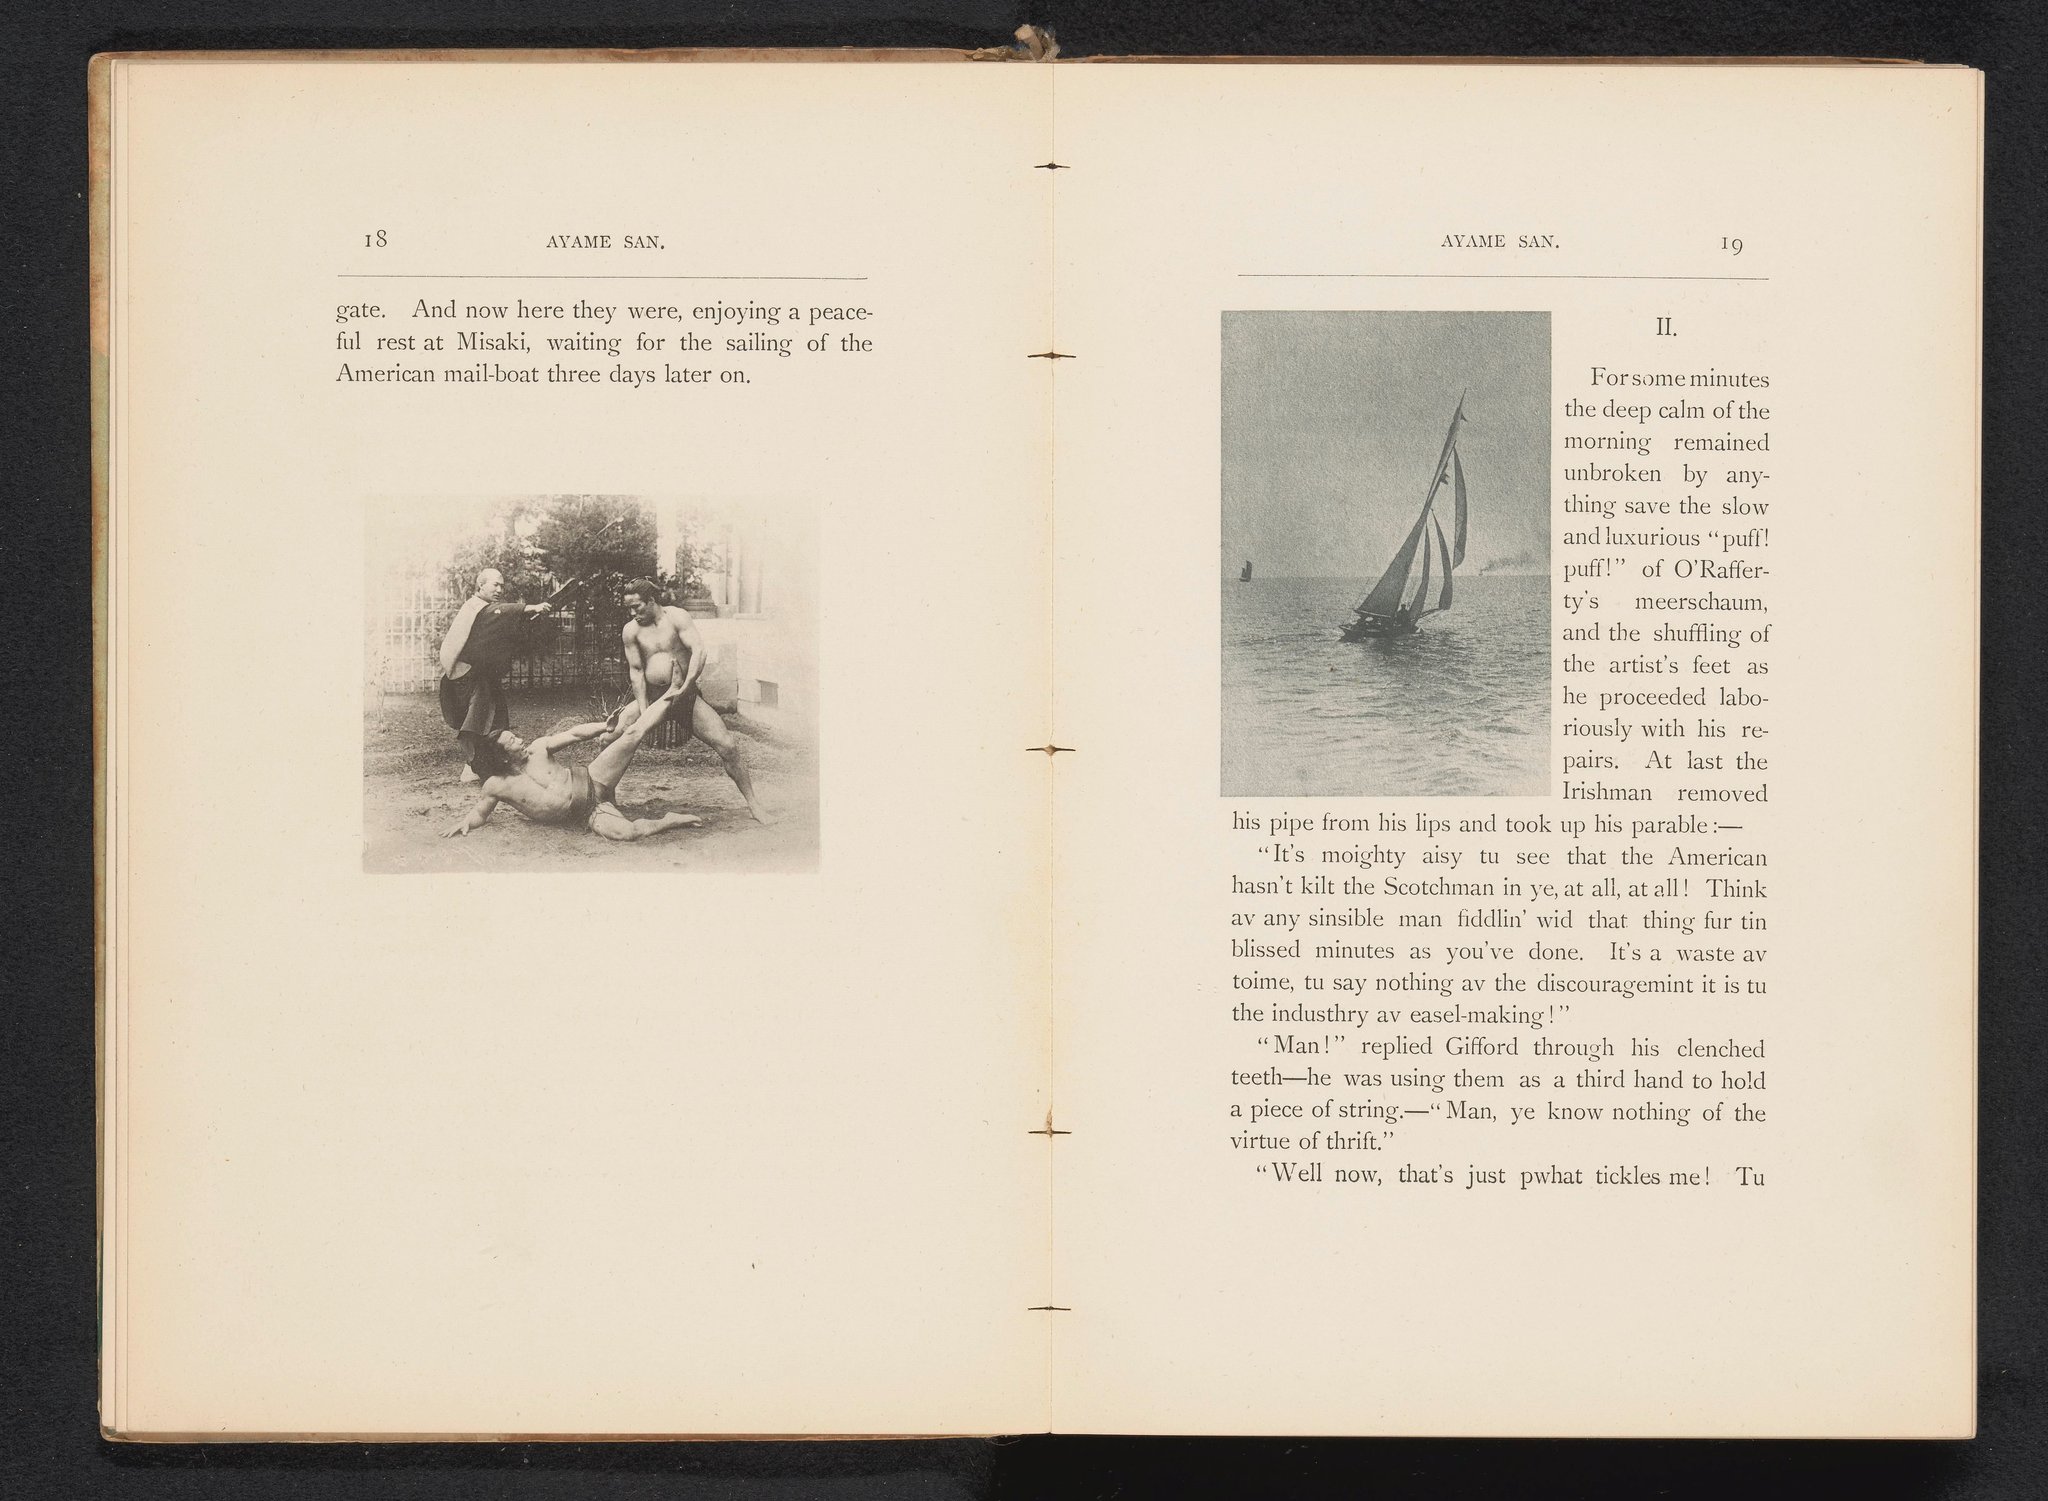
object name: page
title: Zeilschip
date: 1882-1892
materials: paper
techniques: photograph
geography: japan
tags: sailing-ship, sailing-boat